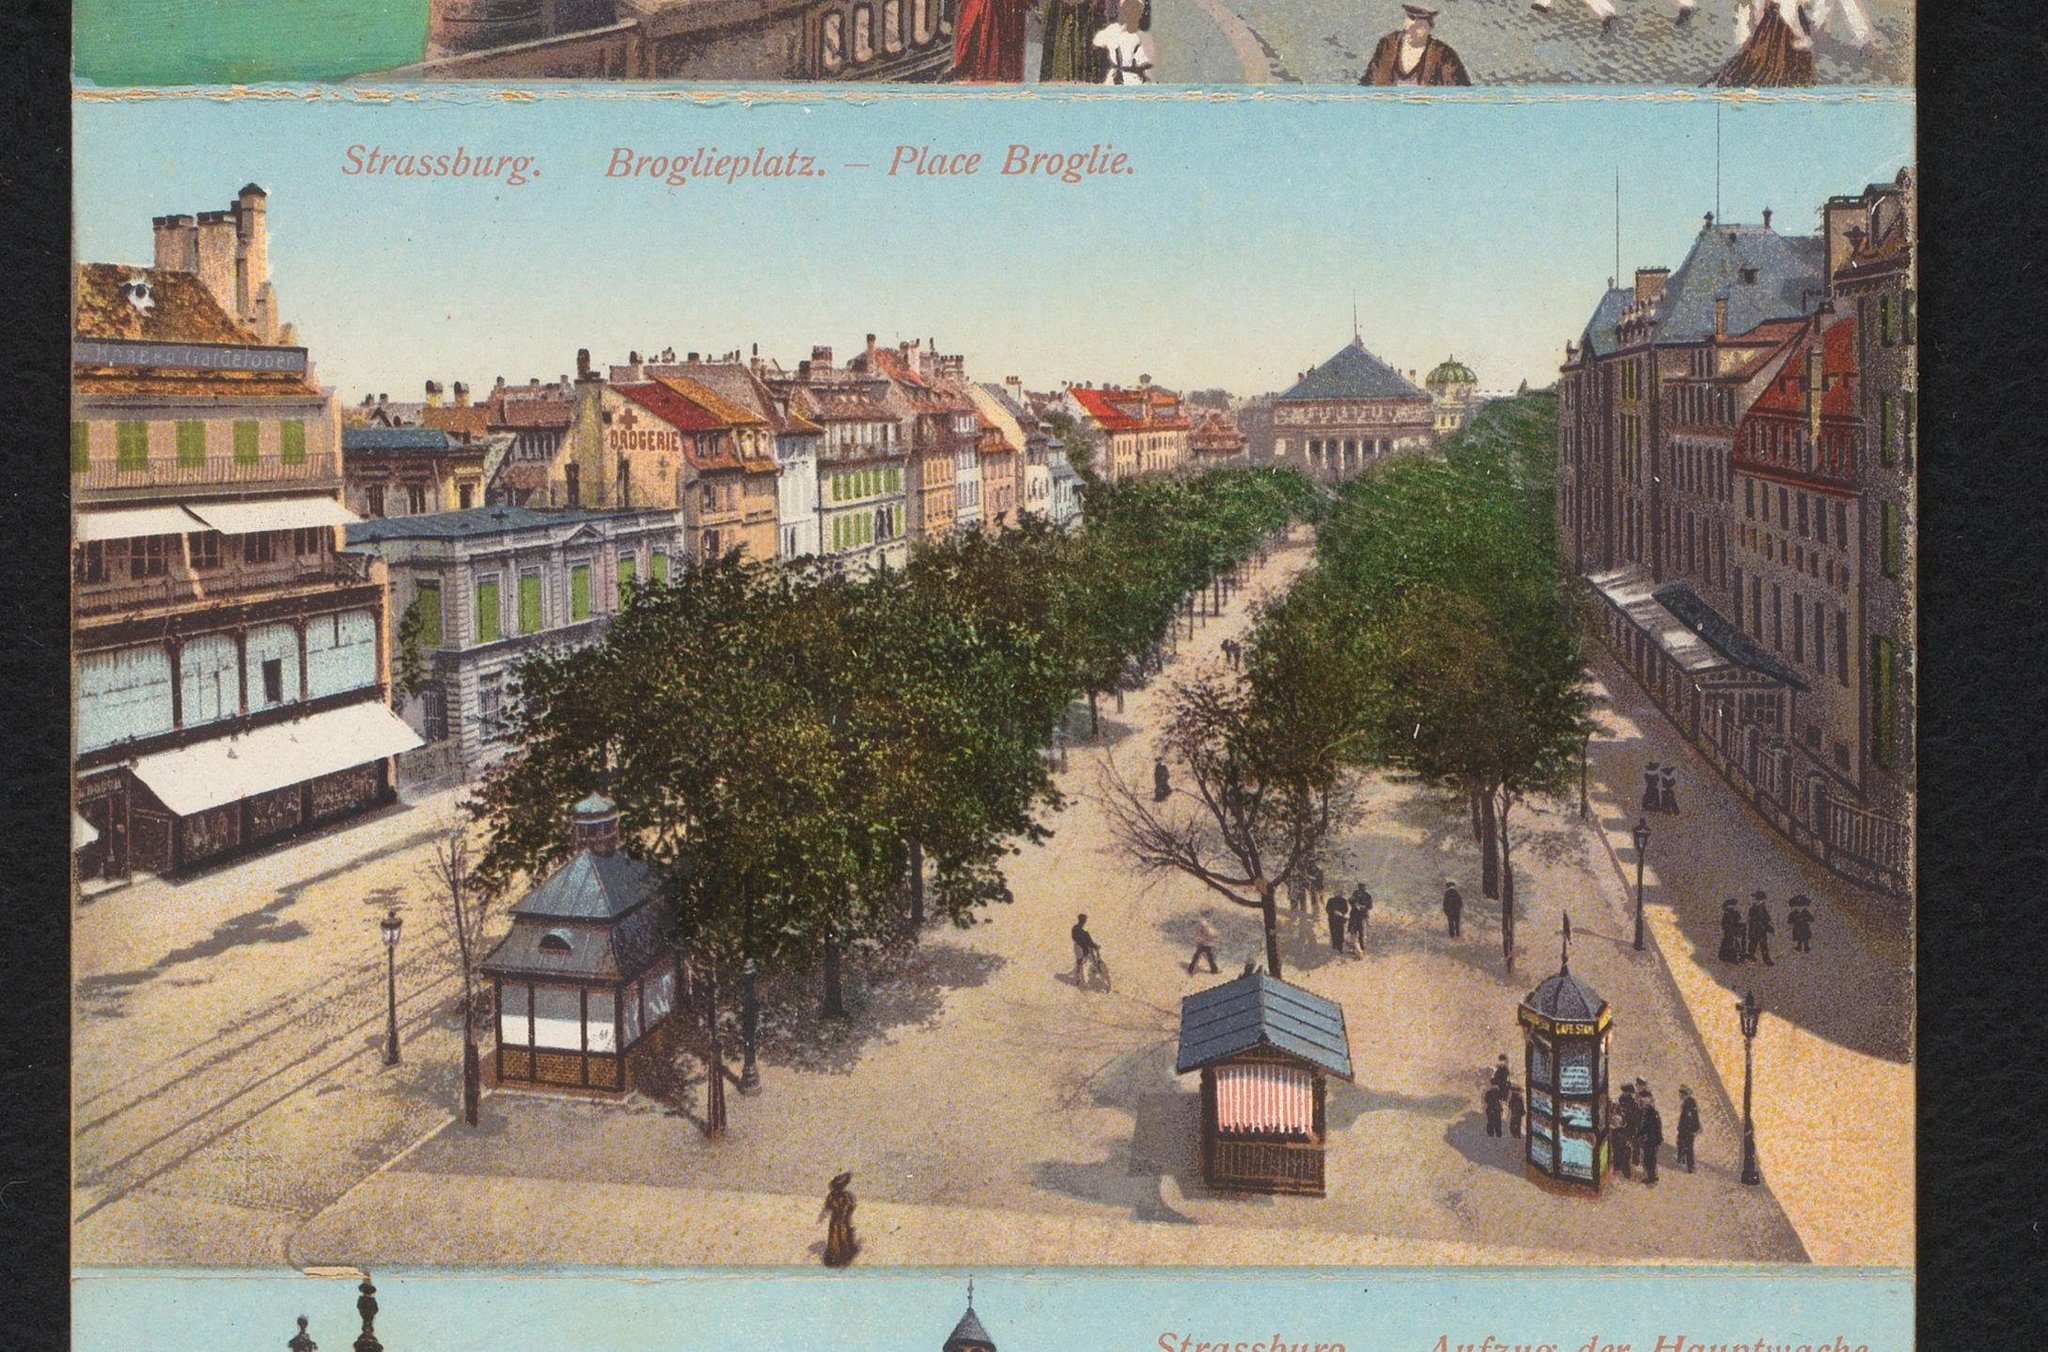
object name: ansichtkaart, prentbriefkaart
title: Strassburg. Broglieplatz / Place Broglie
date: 1905-1930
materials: cardboard, photographic process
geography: straatsburg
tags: square, place, circus, etc., street